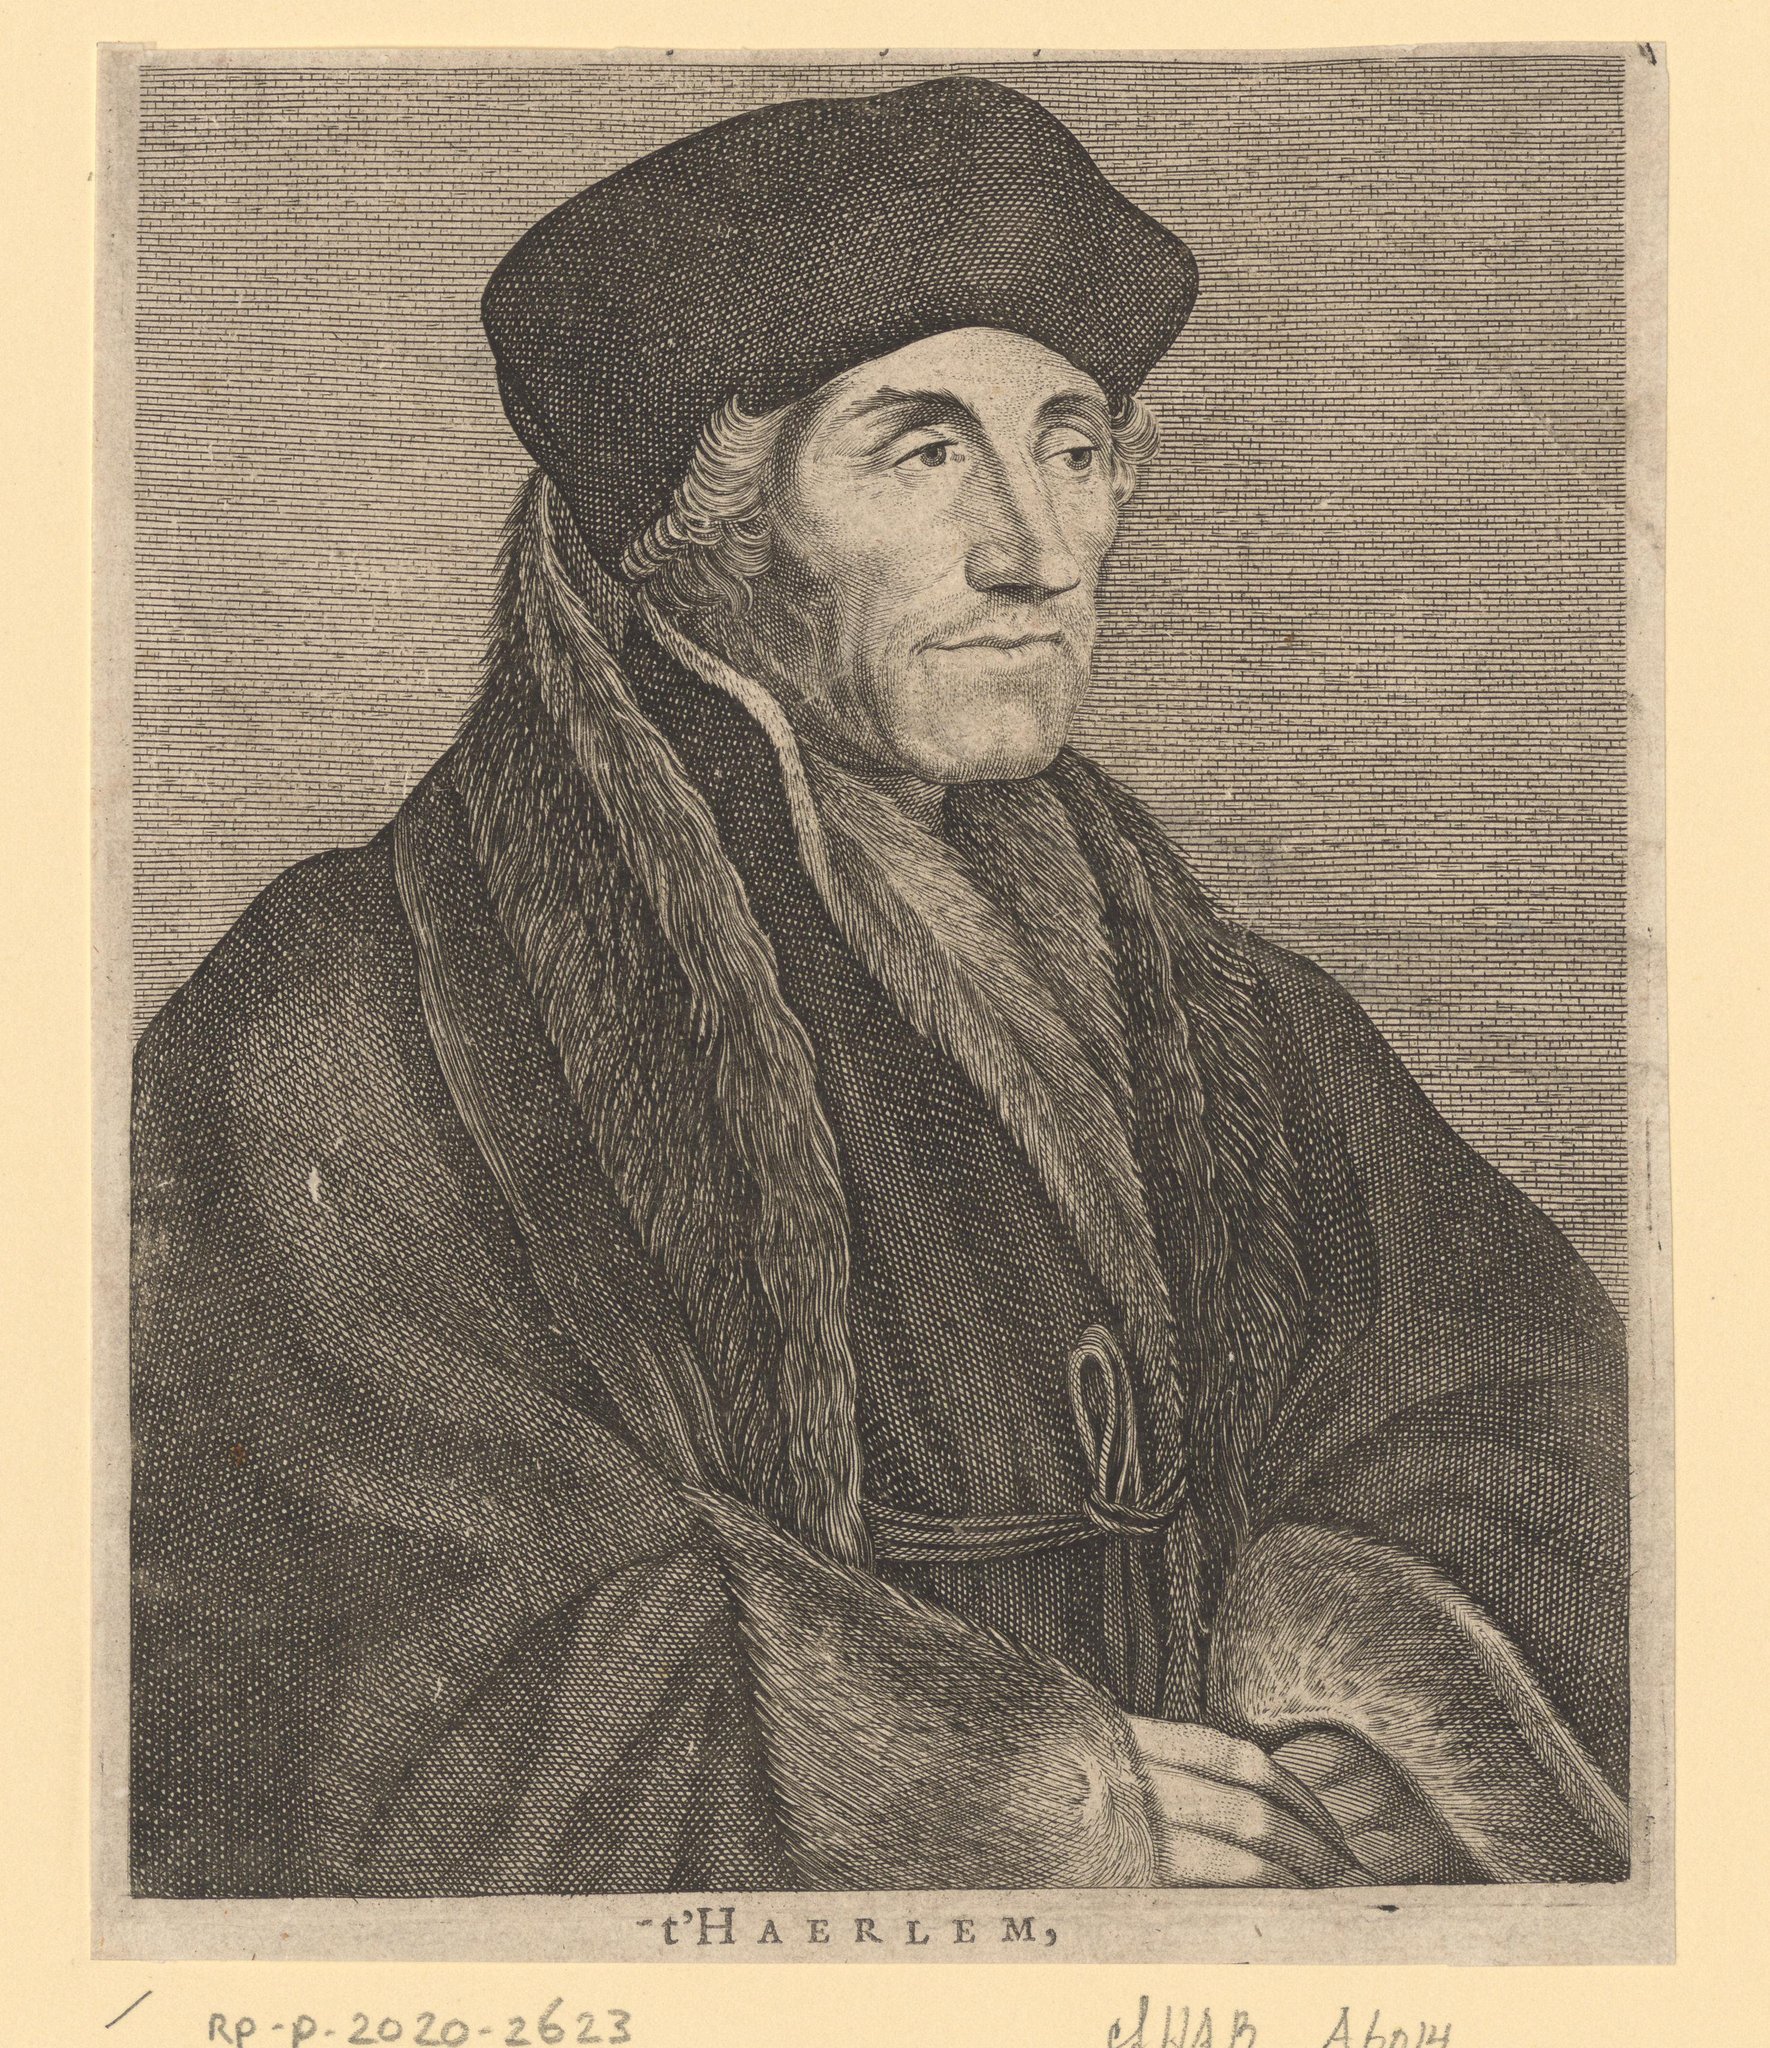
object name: print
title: Portret van Desiderius Erasmus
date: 1630-1680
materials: paper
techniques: engraving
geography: haarlem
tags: rotterdam, desiderius erasmus, historical persons, scholar, philosopher (+ portrait of scholar, scientist)